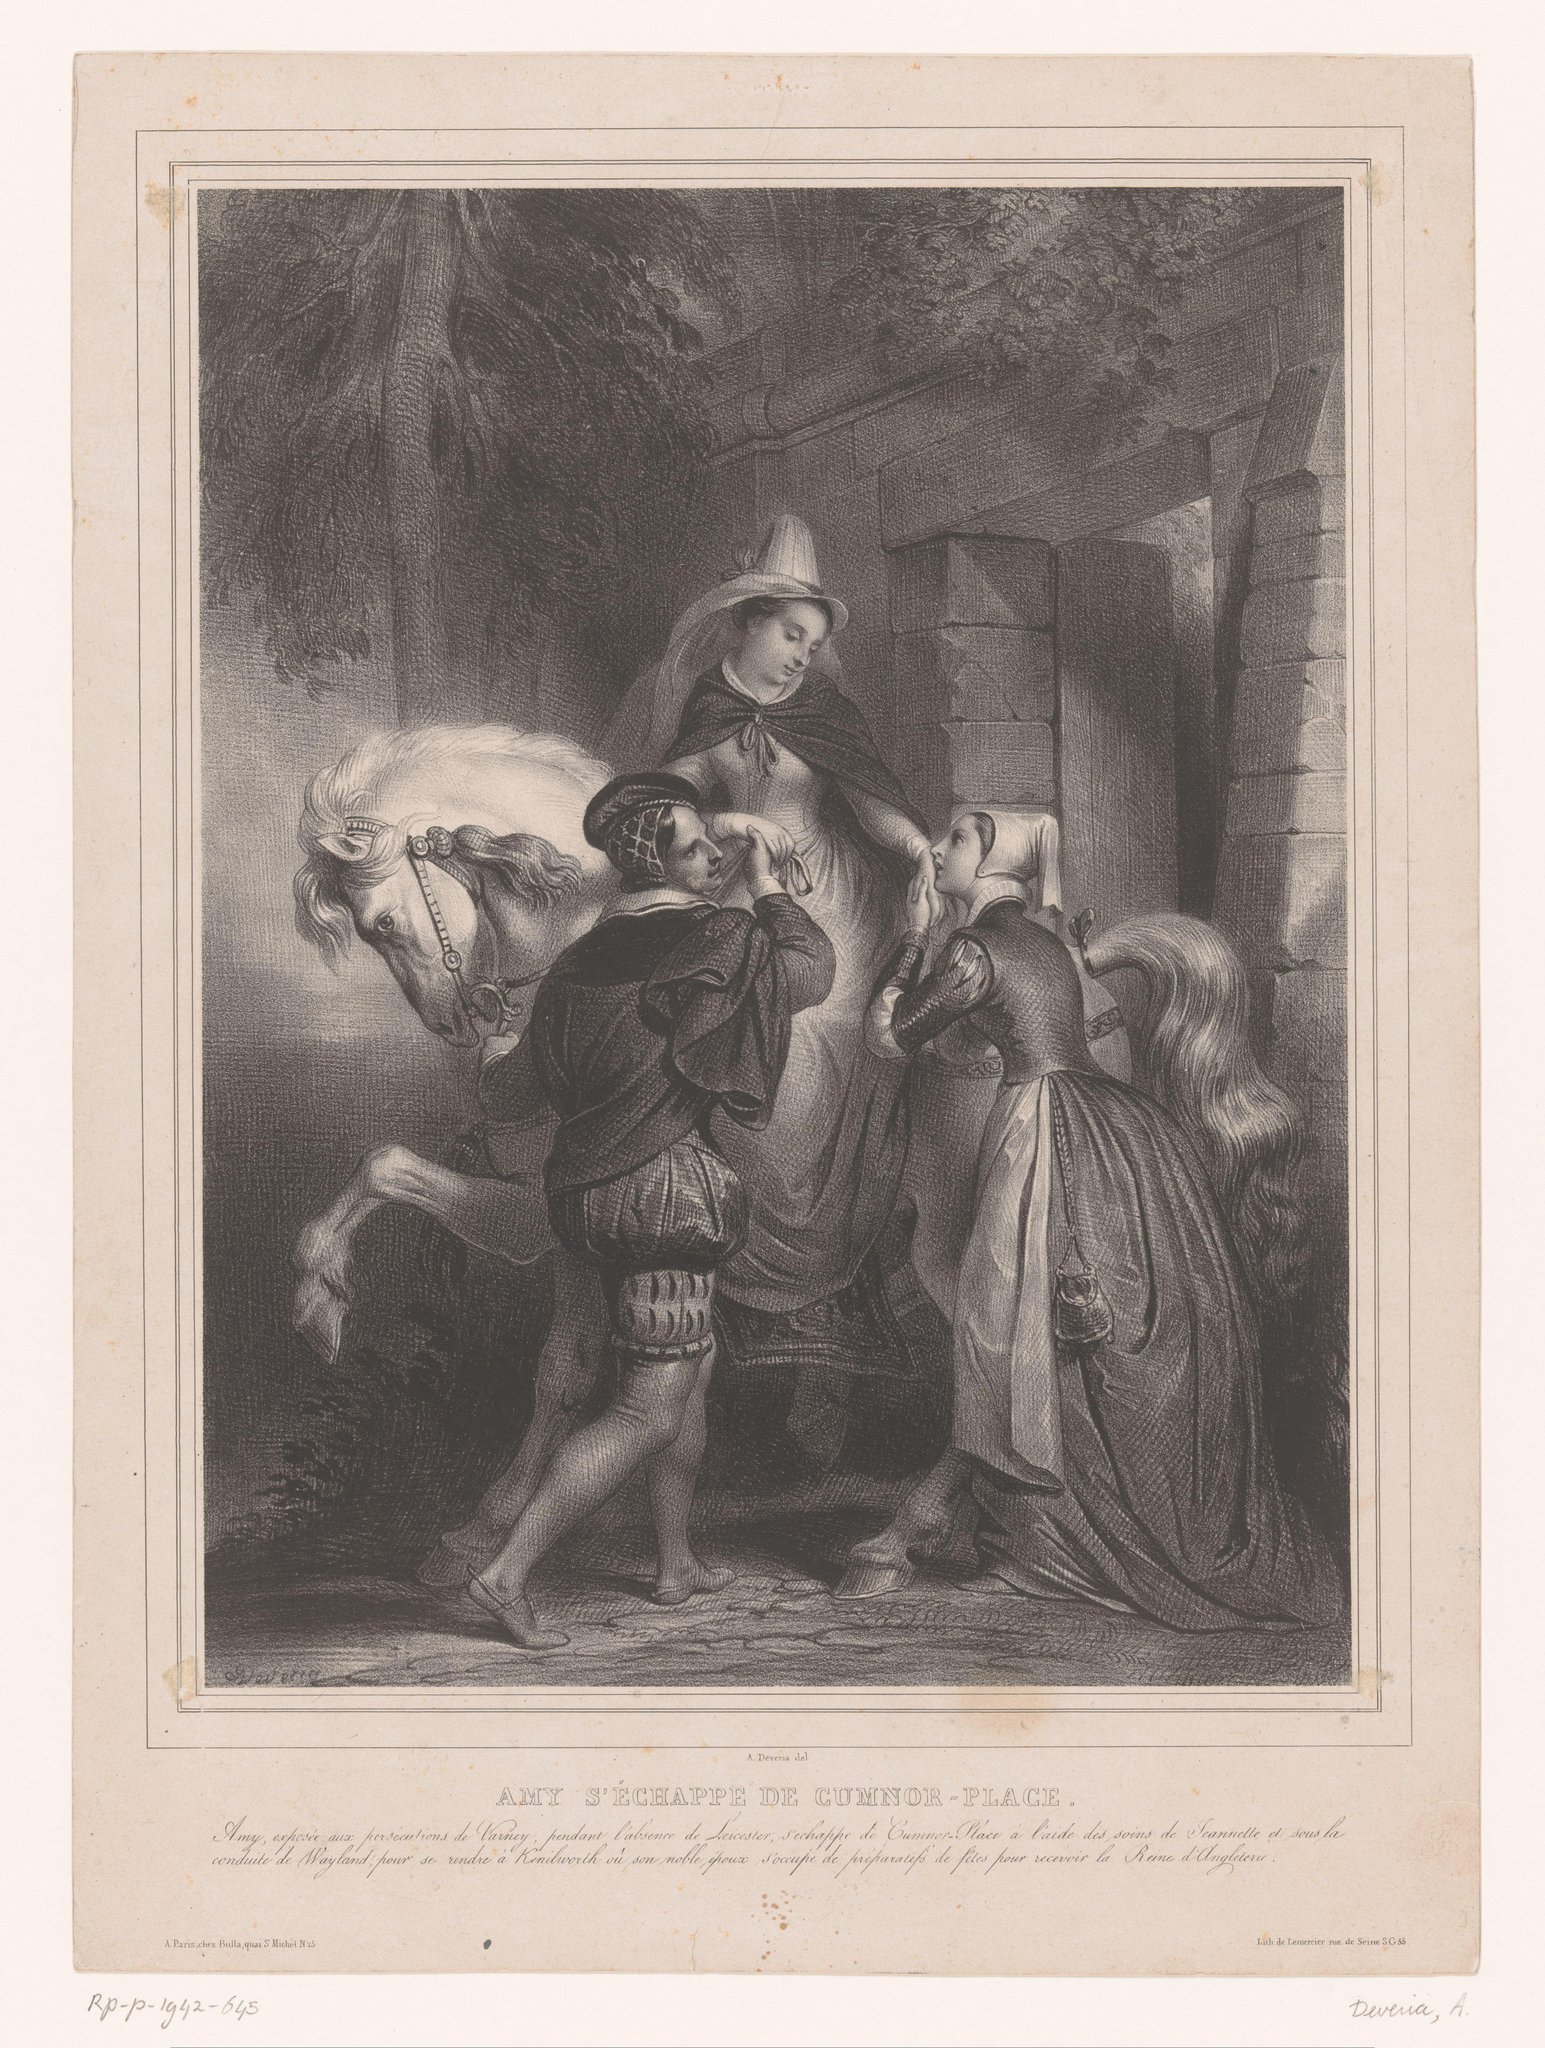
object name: print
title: Amy s'échappe de Cumnor-Place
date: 1837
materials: paper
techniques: lithograph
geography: paris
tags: (scenes from) specific works of literature (with author, title), historical persons, flight, running away; pursuing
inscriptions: check stamp: Lugt 4088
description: Scène uit de historische roman 'Kenilworth' van (Sir) Walter Scott (1821).